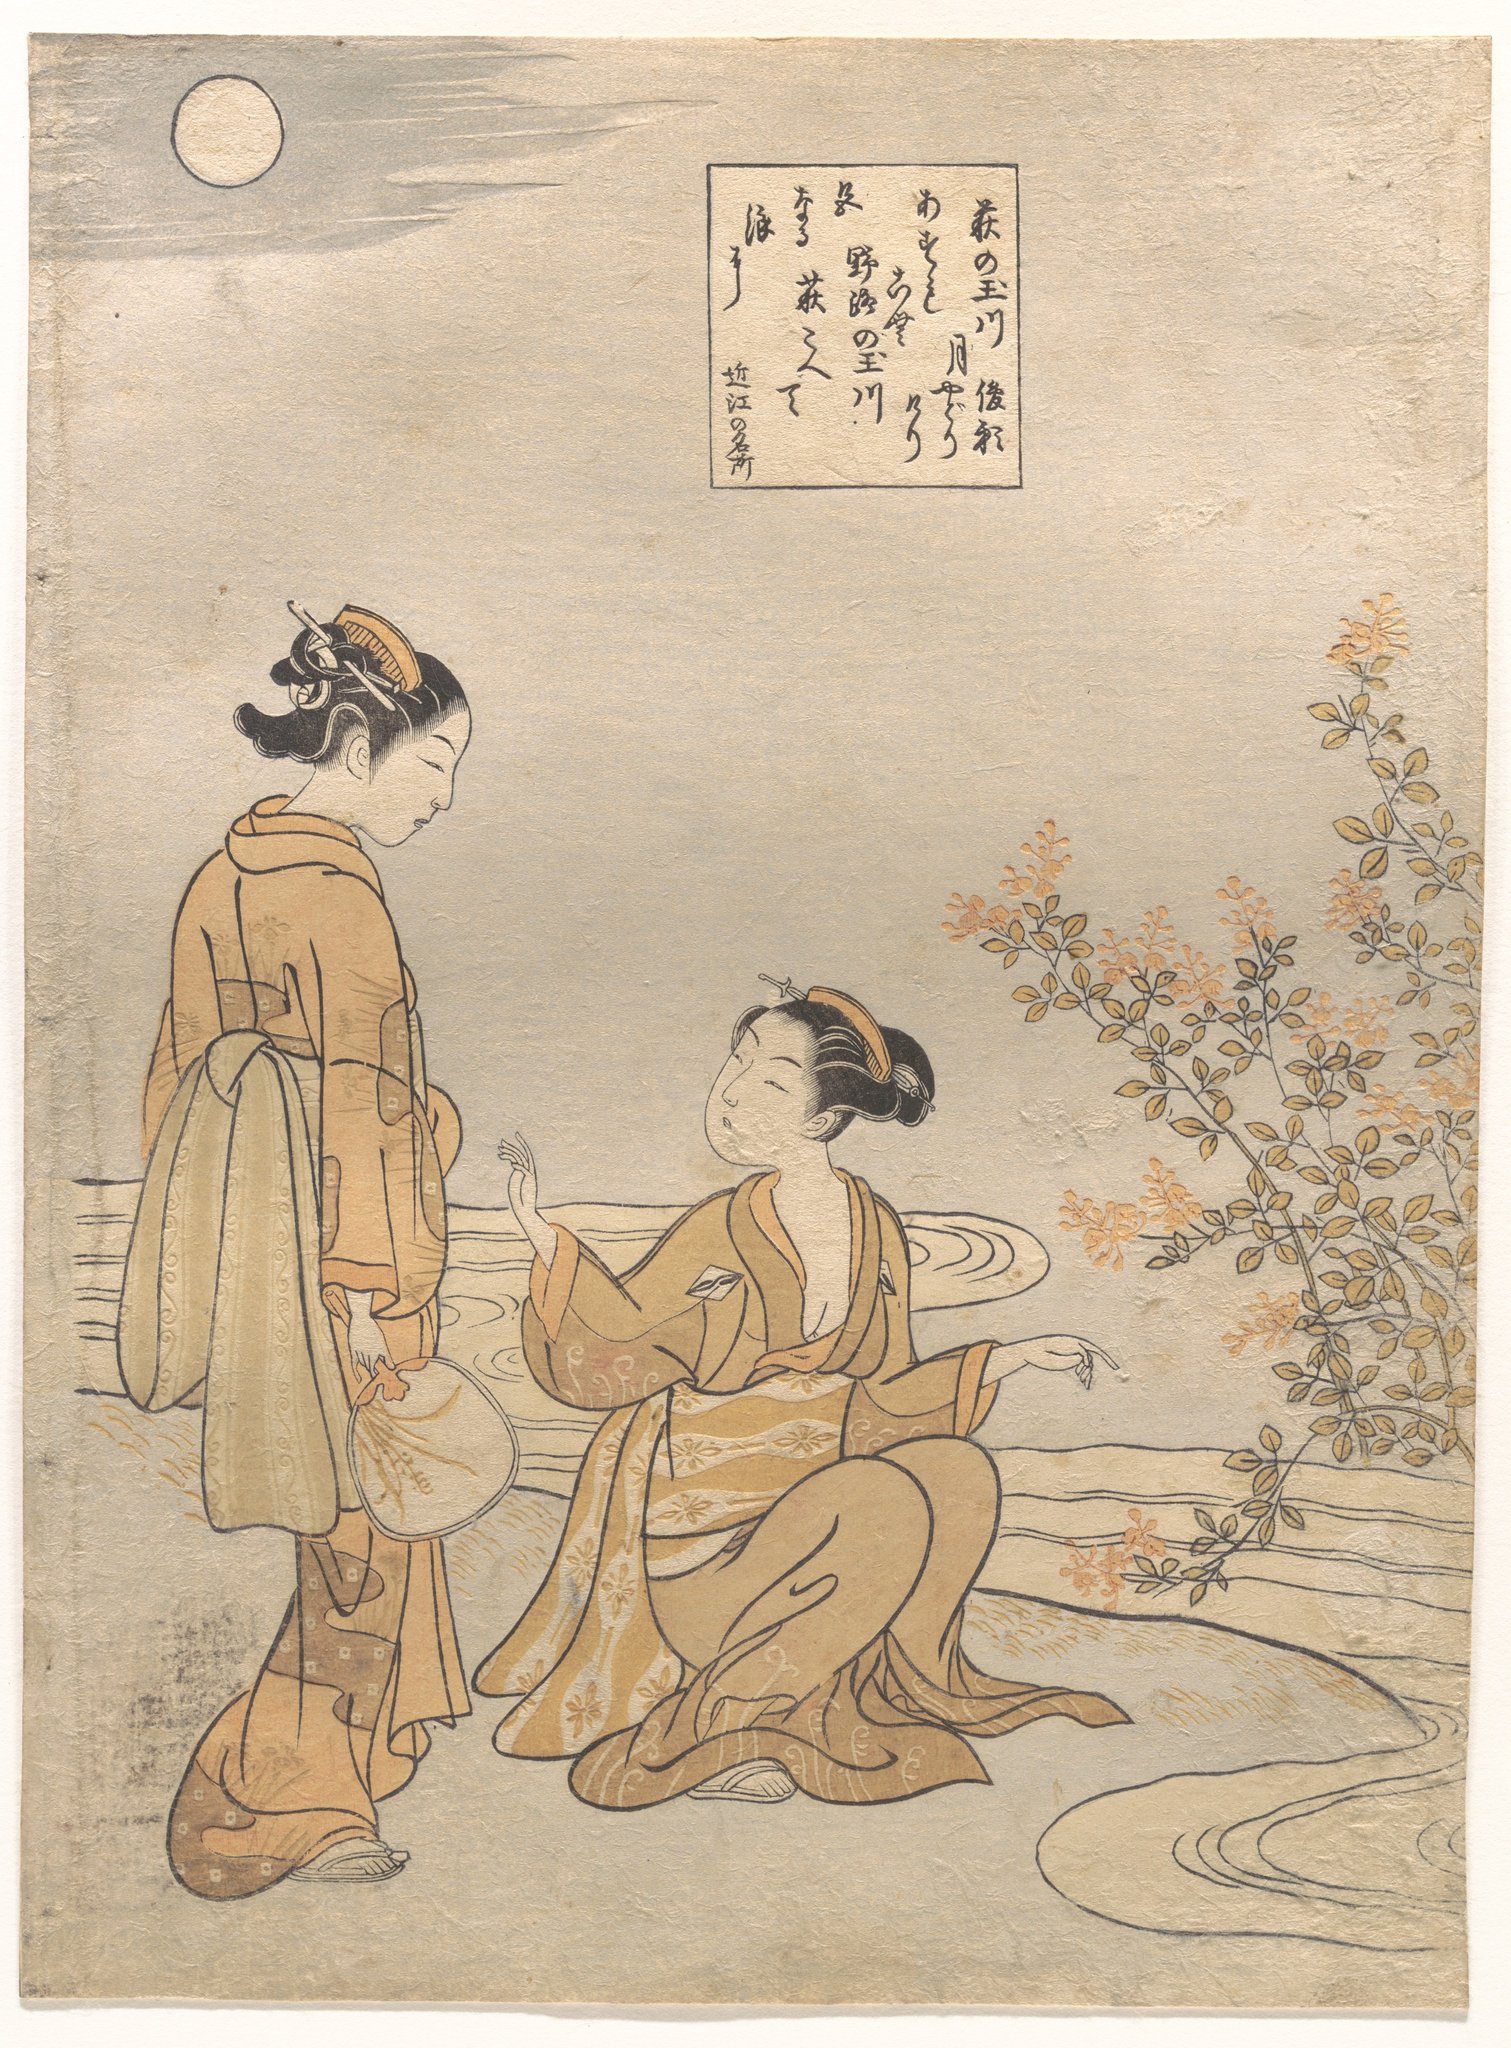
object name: print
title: Hagi no Tamagawa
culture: japanese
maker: suzuki harunobu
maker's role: artist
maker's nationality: japanese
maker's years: 1725-1770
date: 1725-1770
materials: ink, paper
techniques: woodblock print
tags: women,rivers,plants